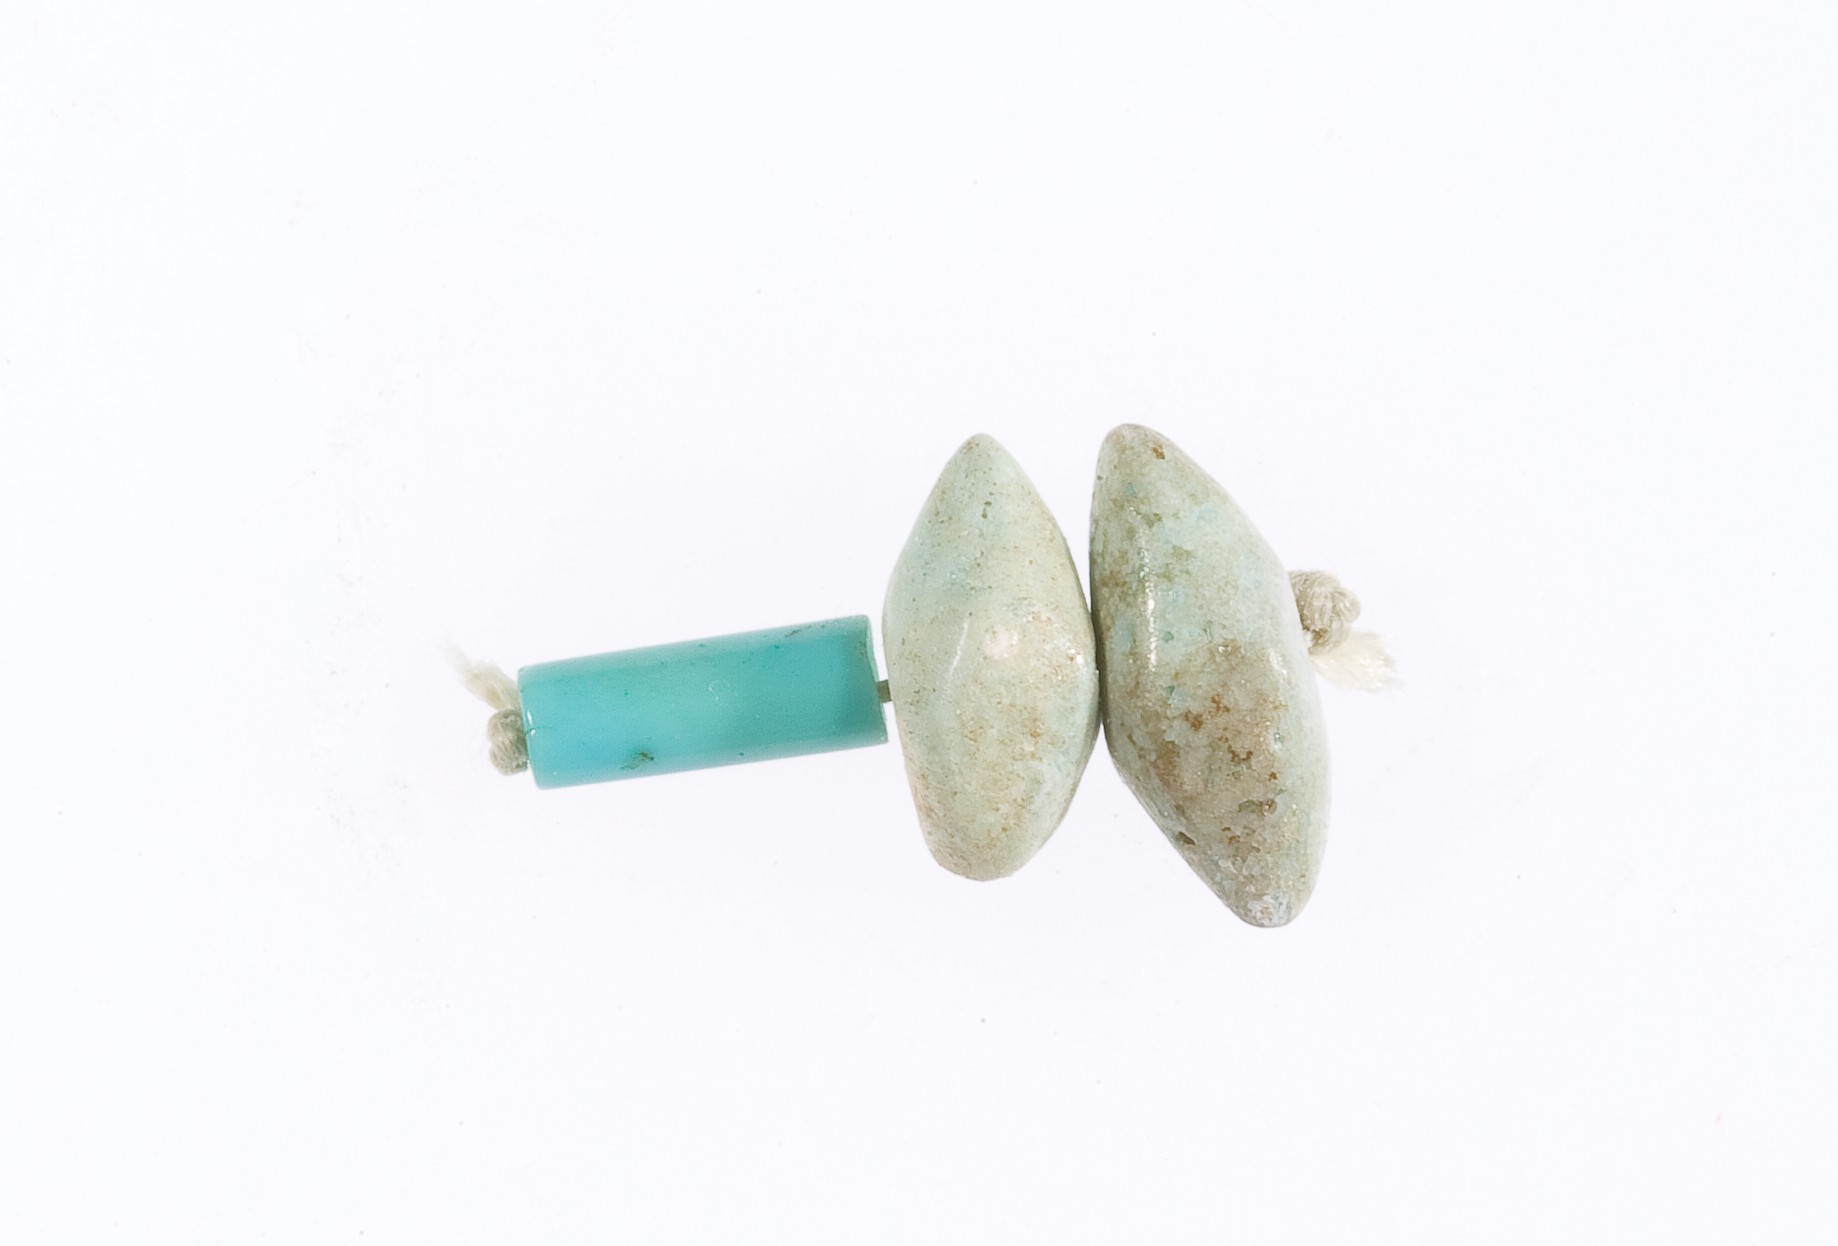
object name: bead, cylinder, pendant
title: Beads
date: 1981-1640 BCE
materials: faience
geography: egypt